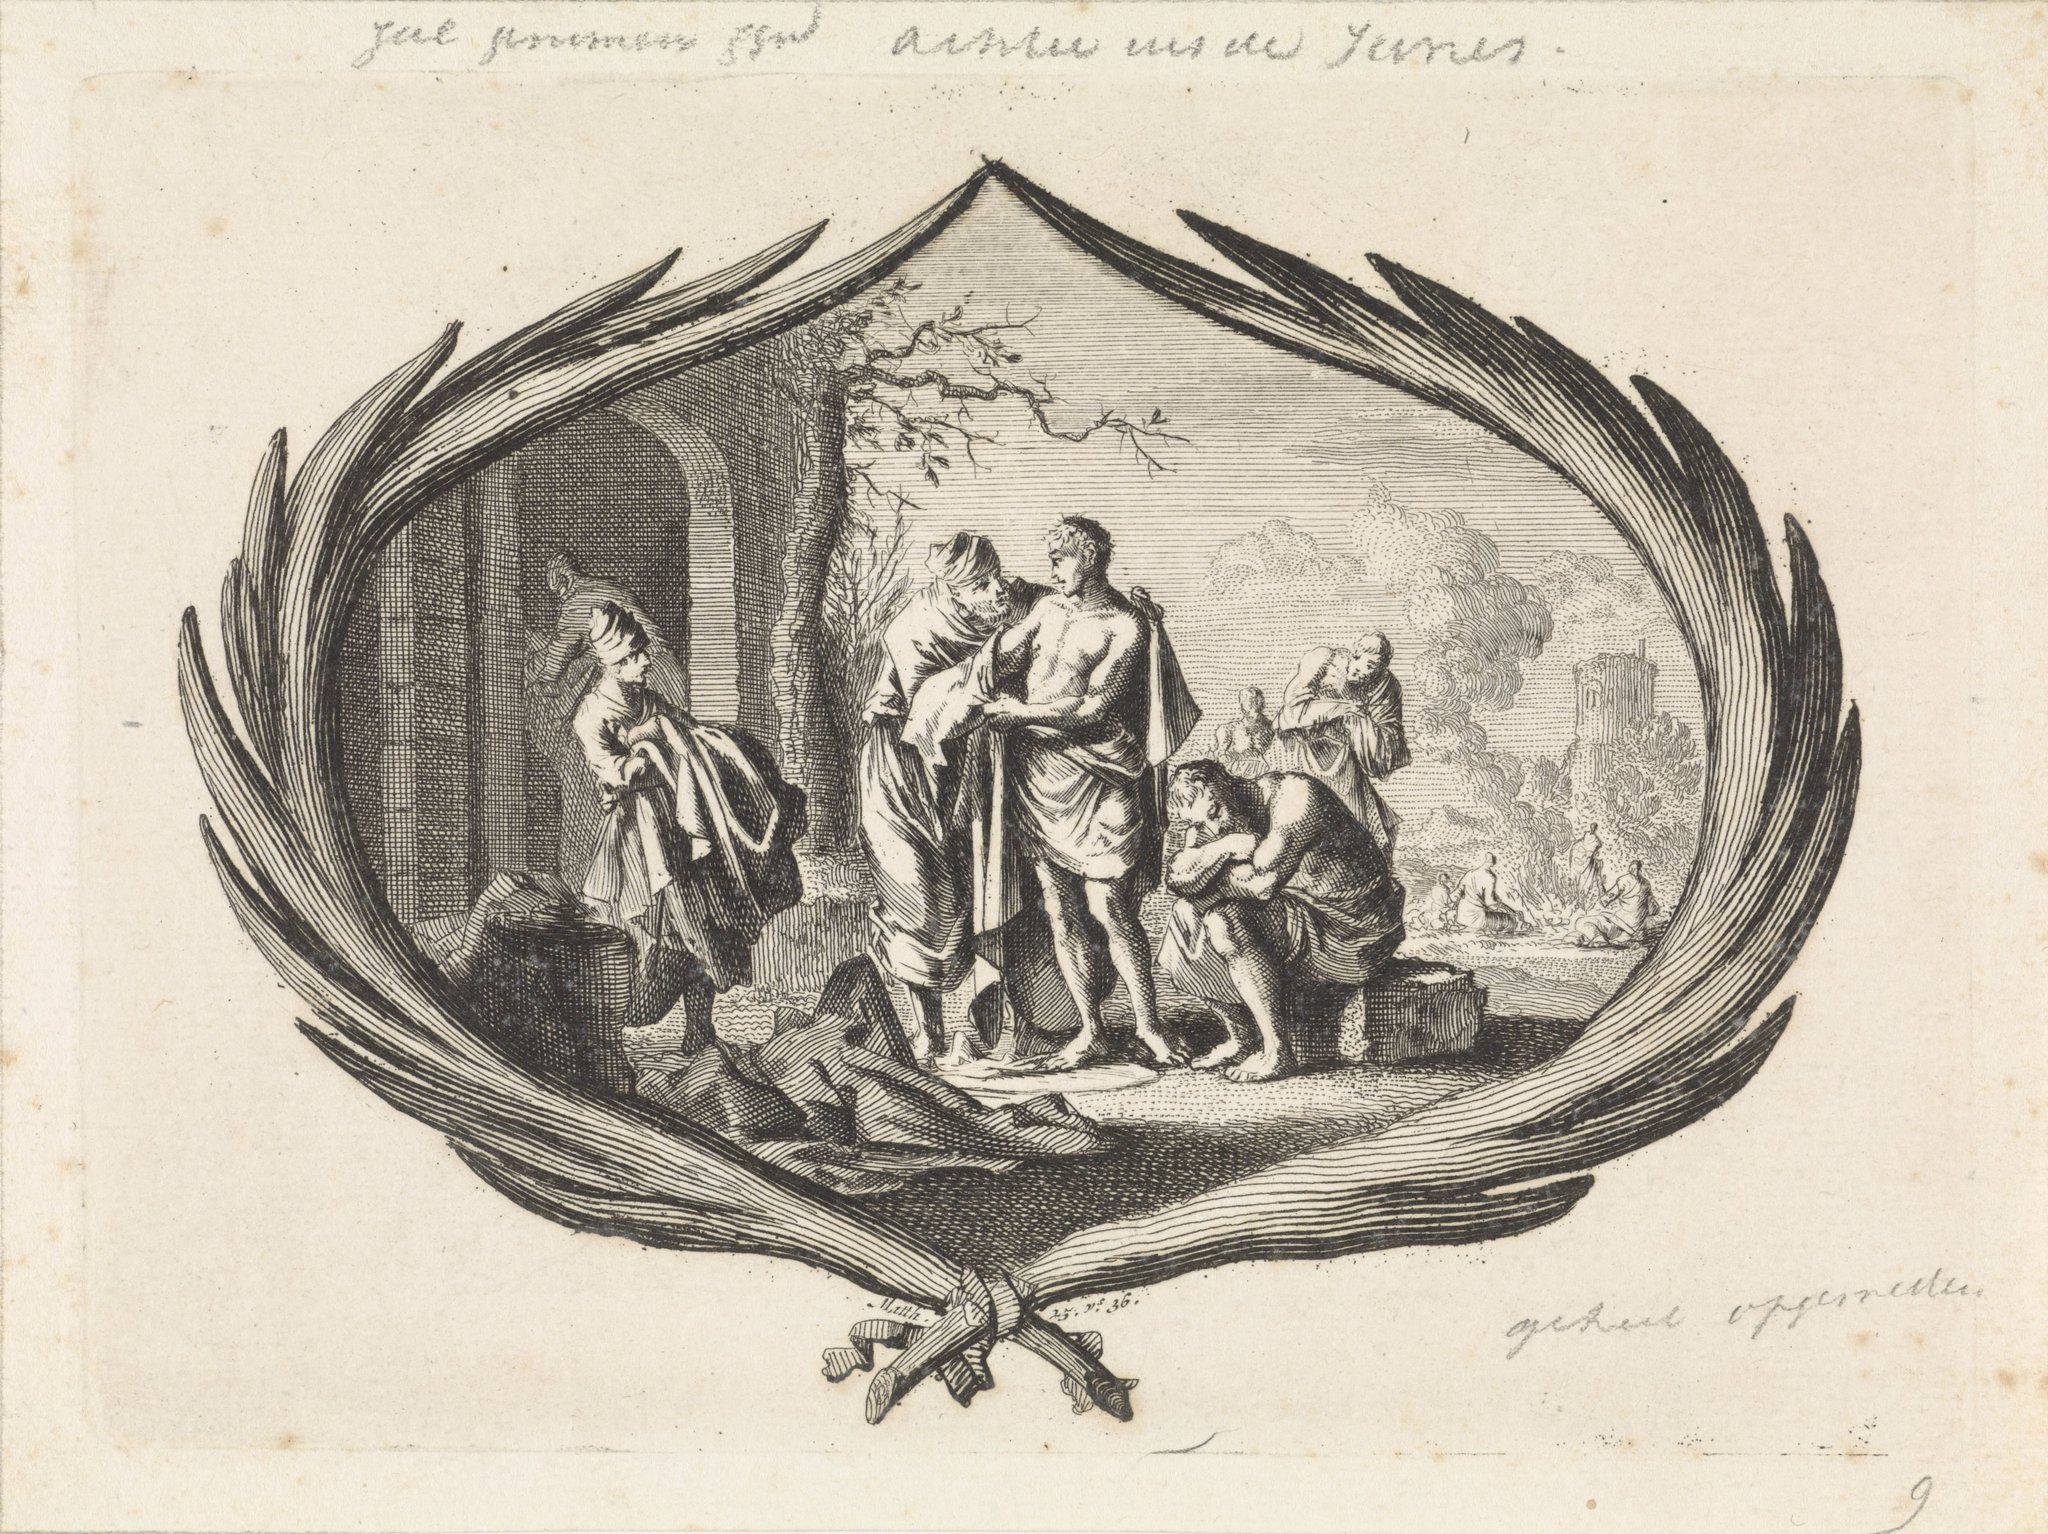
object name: print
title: Naakten kleden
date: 1700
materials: paper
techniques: etching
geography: amsterdam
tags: ornament ~ cartouche, clothing the naked, 'nudus vestitur' ~ one of the (seven) acts of mercy, the poor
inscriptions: collector's mark: Lugt 2228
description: Een voorstelling in een cartouche van palmtakken. Een man deelt voor zijn huis kleren uit aan naakte armen, een van de werken van barmhartigheid. Onder de cartouche de Bijbelreferentie Mat. 25:36.